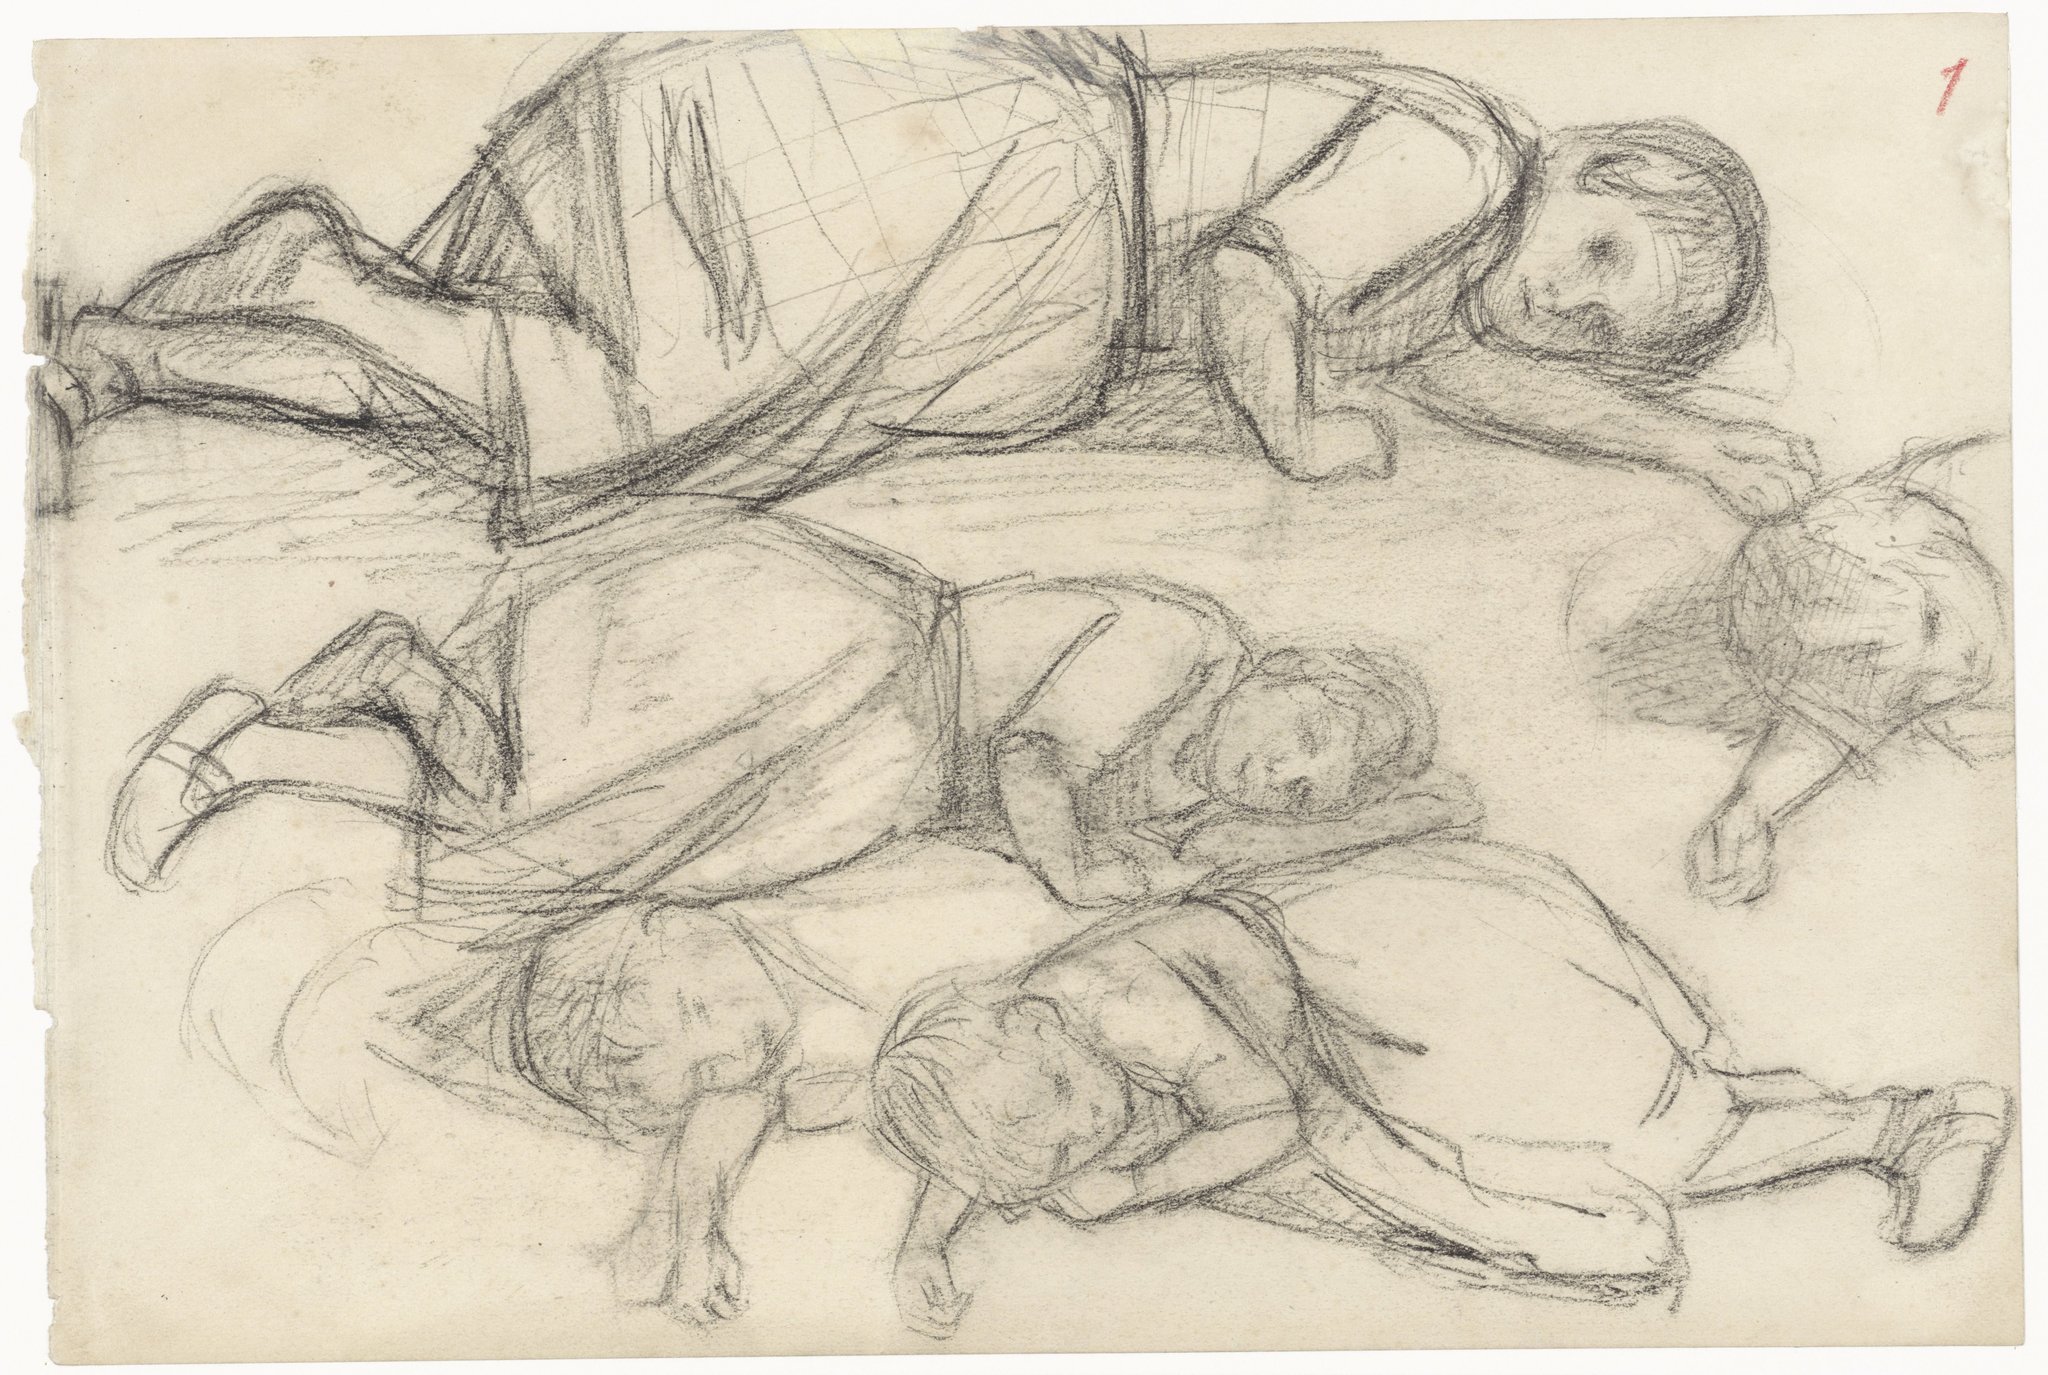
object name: drawing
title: Studies van een liggend meisje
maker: jozef israëls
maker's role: draughtsman, painter, print maker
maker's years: 1824-1911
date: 1834-1911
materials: chalk, paper